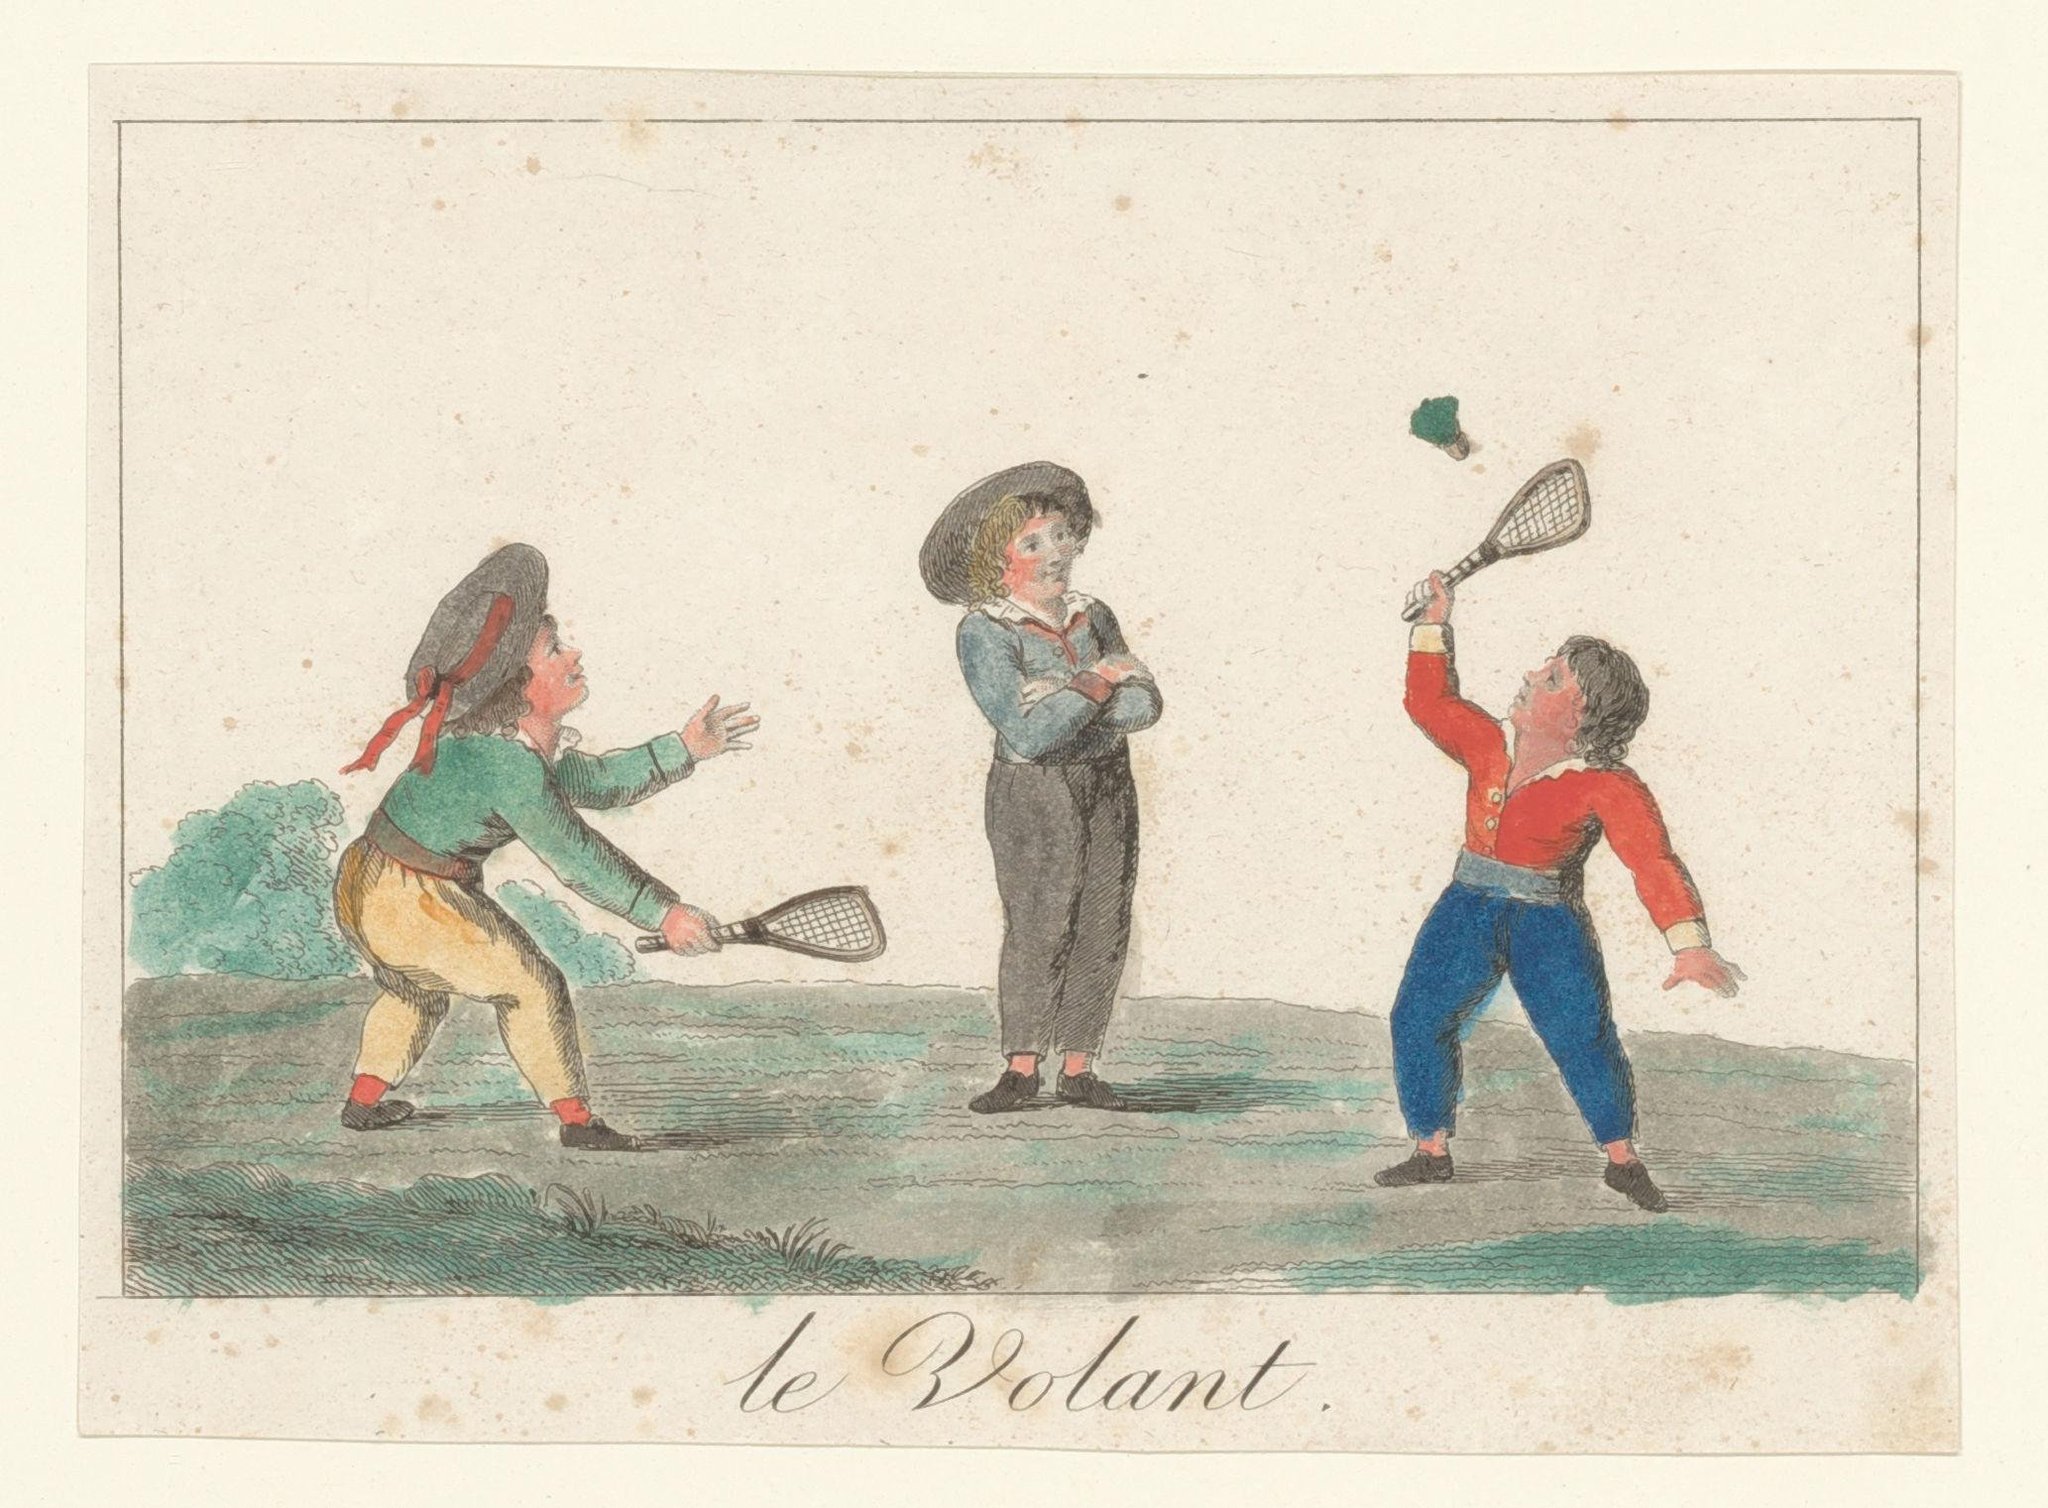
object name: print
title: Le Volant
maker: Anonymous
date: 1800-1899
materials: paper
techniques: etching, hand coloring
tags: children's games and plays, throwing games, 'jeu de volant', badminton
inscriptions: stamp, collector's mark: Lugt 1641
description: Onderwerpsrubrieken binnen de Atlas Zeden en Gewoonten: Zeden en Gewoonten in Engeren Zin, Des menschen beging, midden en einde, Kinderleven – Kinderspel en Kinderprenten.